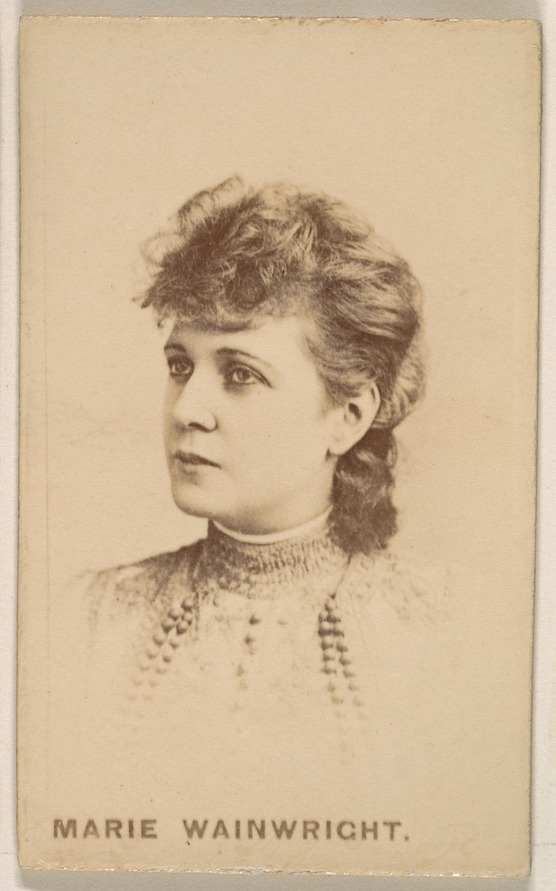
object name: photograph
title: Marie Wainwright, from the Actresses series (N246), Type 1, issued by Kinney Brothers to promote Sporting Extra Cigarettes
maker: kinney brothers tobacco company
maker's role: publisher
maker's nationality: american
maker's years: 1869-2011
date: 1890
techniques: albumen silver print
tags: portraits,women,actresses